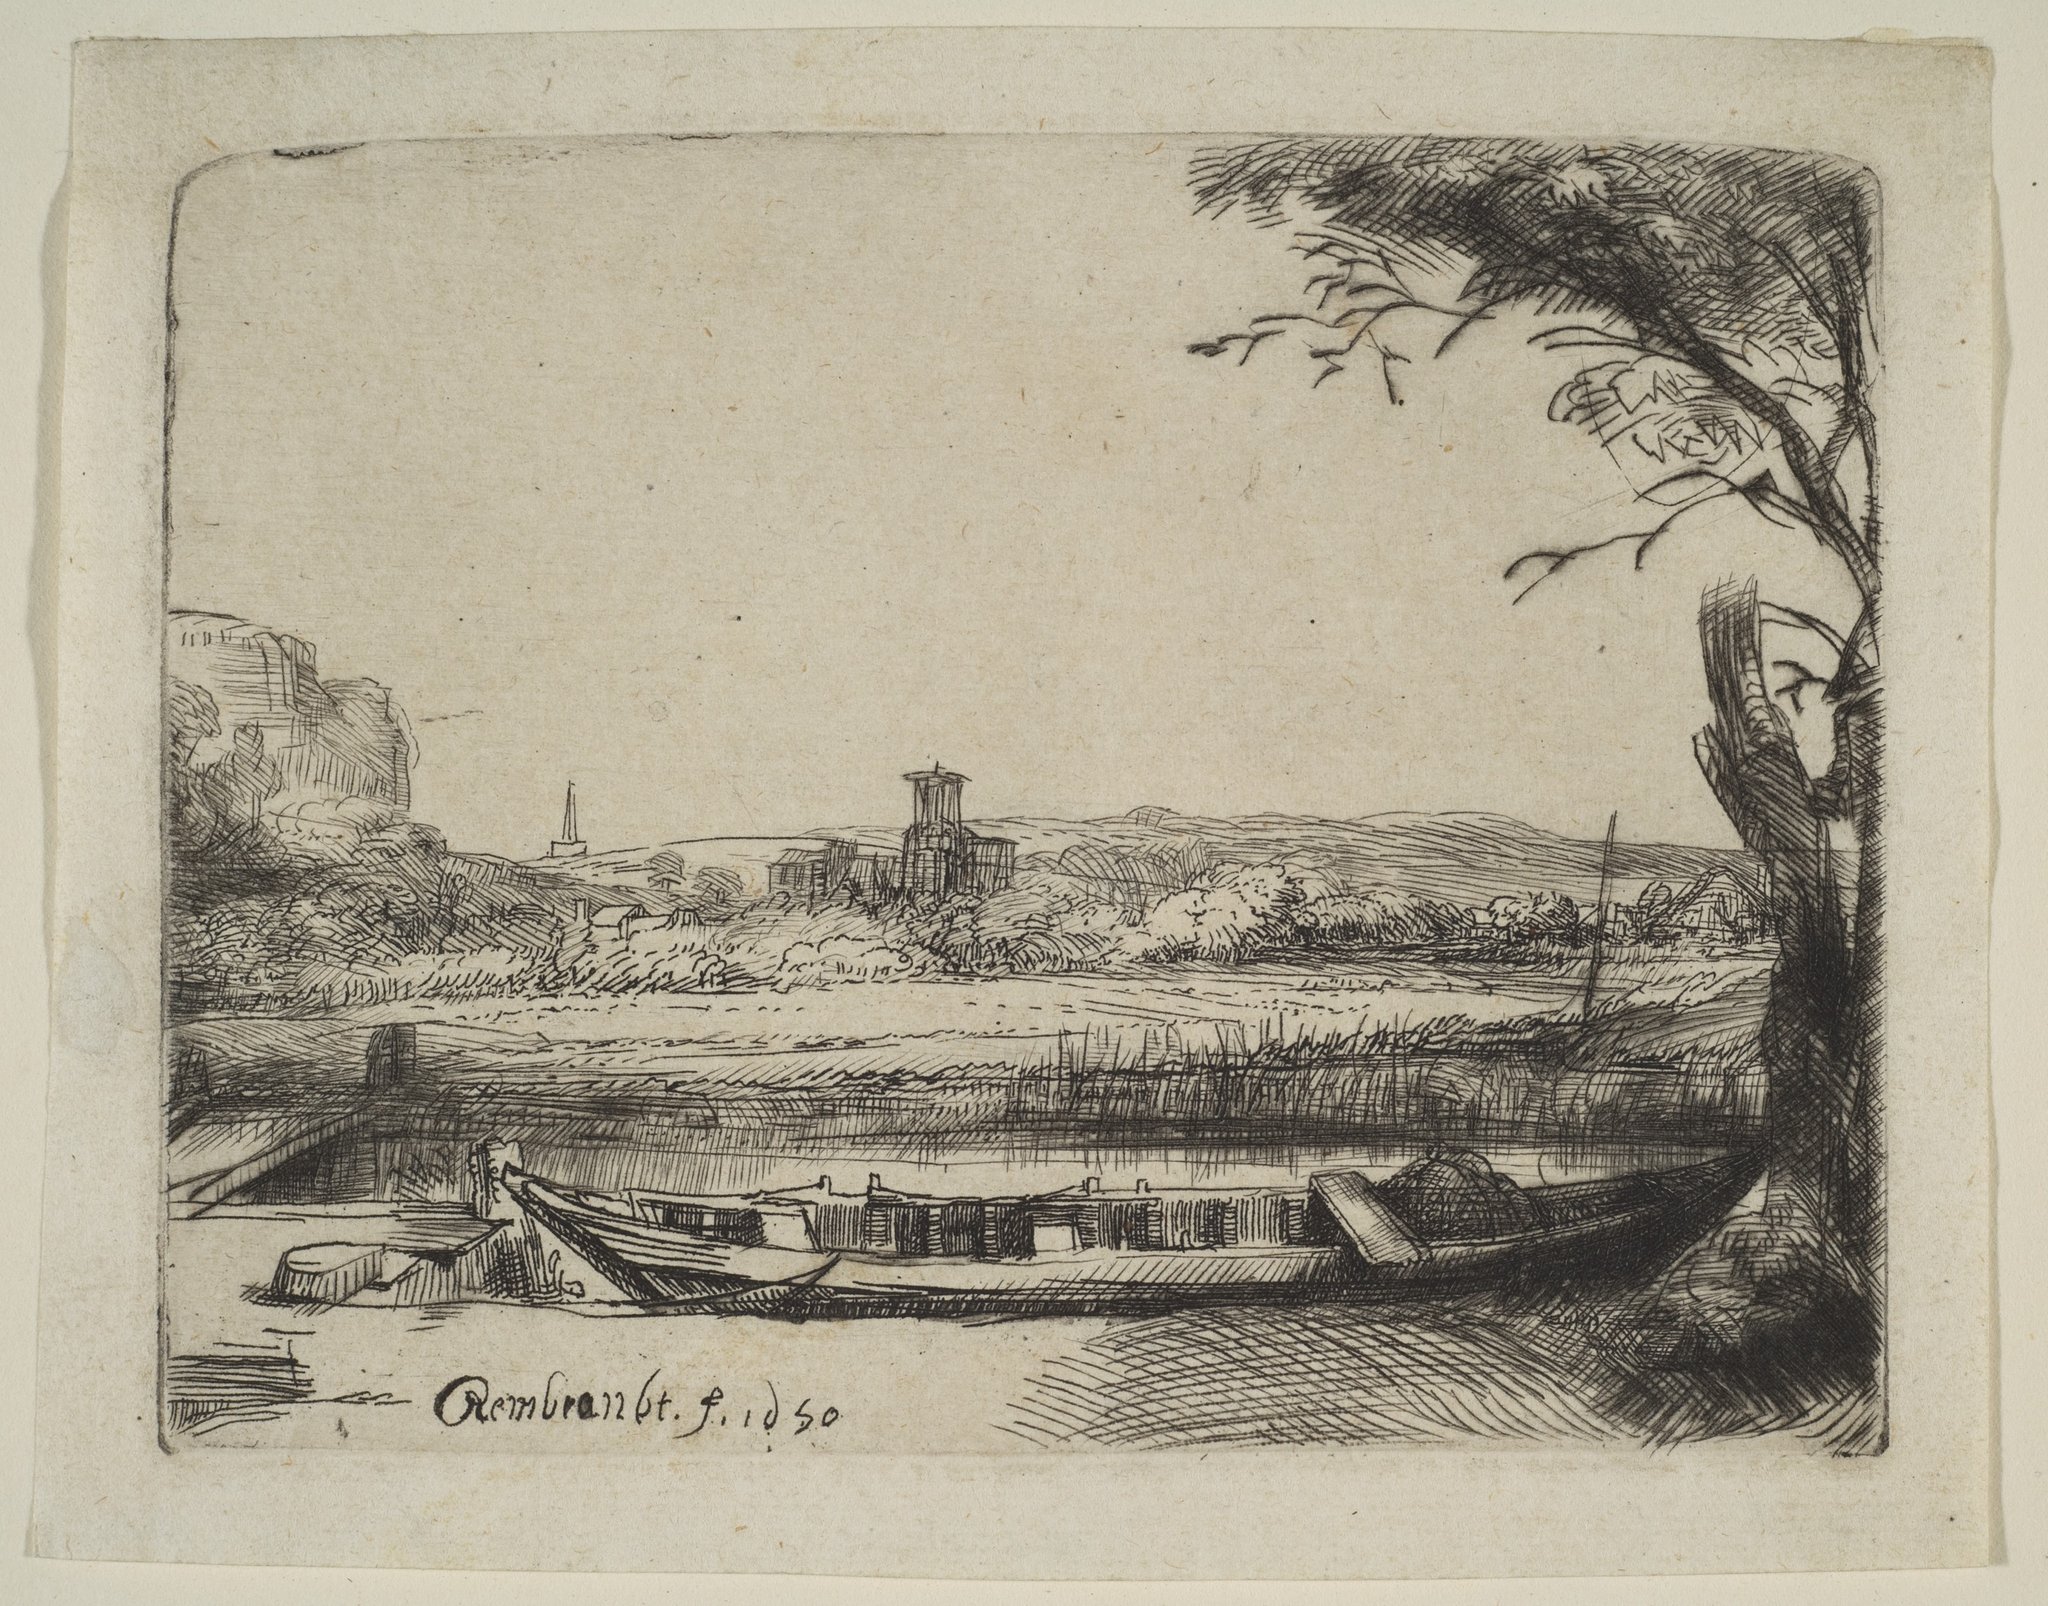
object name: print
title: Canal with a Large Boat and a Bridge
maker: rembrandt van rijn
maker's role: artist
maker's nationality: dutch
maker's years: 1606-1669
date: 1650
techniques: drypoint, etching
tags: bridges,canals,boats